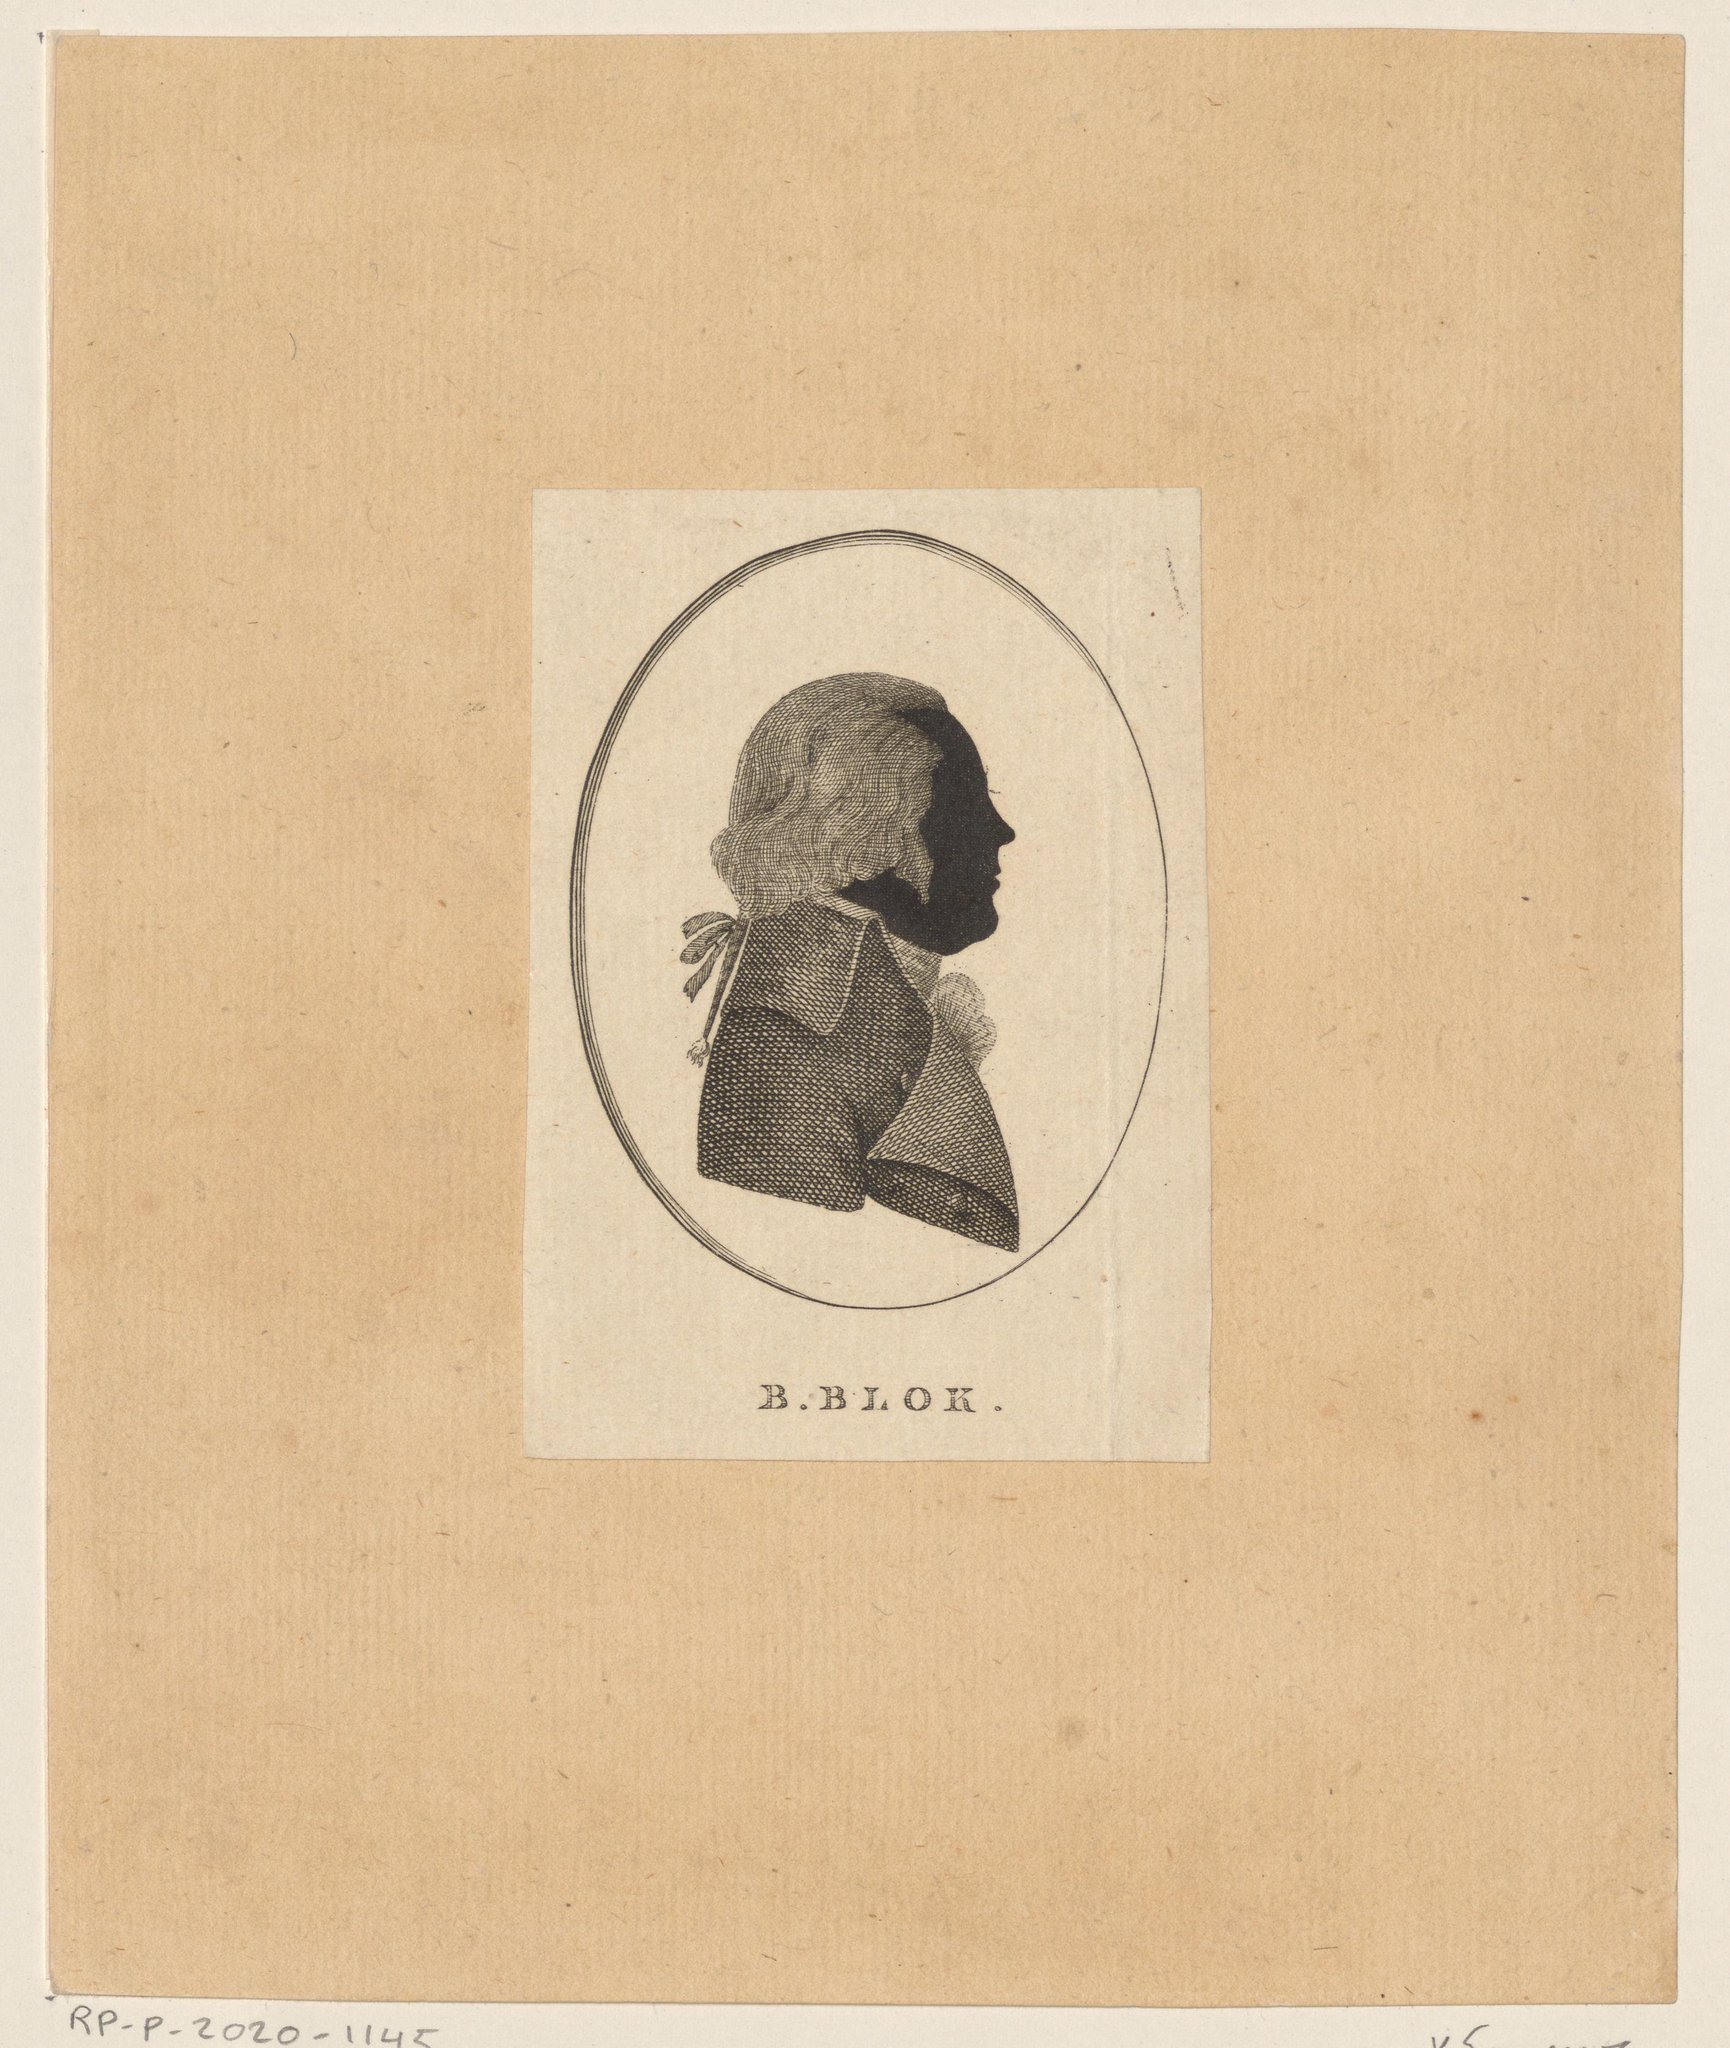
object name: print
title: Silhouetportret van Bernardus Blok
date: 1799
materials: paper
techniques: etching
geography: amsterdam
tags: historical persons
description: Prent uit: Rogge, Cornelis. Geschiedenis der staatsregeling, voor het Bataafsche volk. Amsterdam: Johannes Allart, 1799.